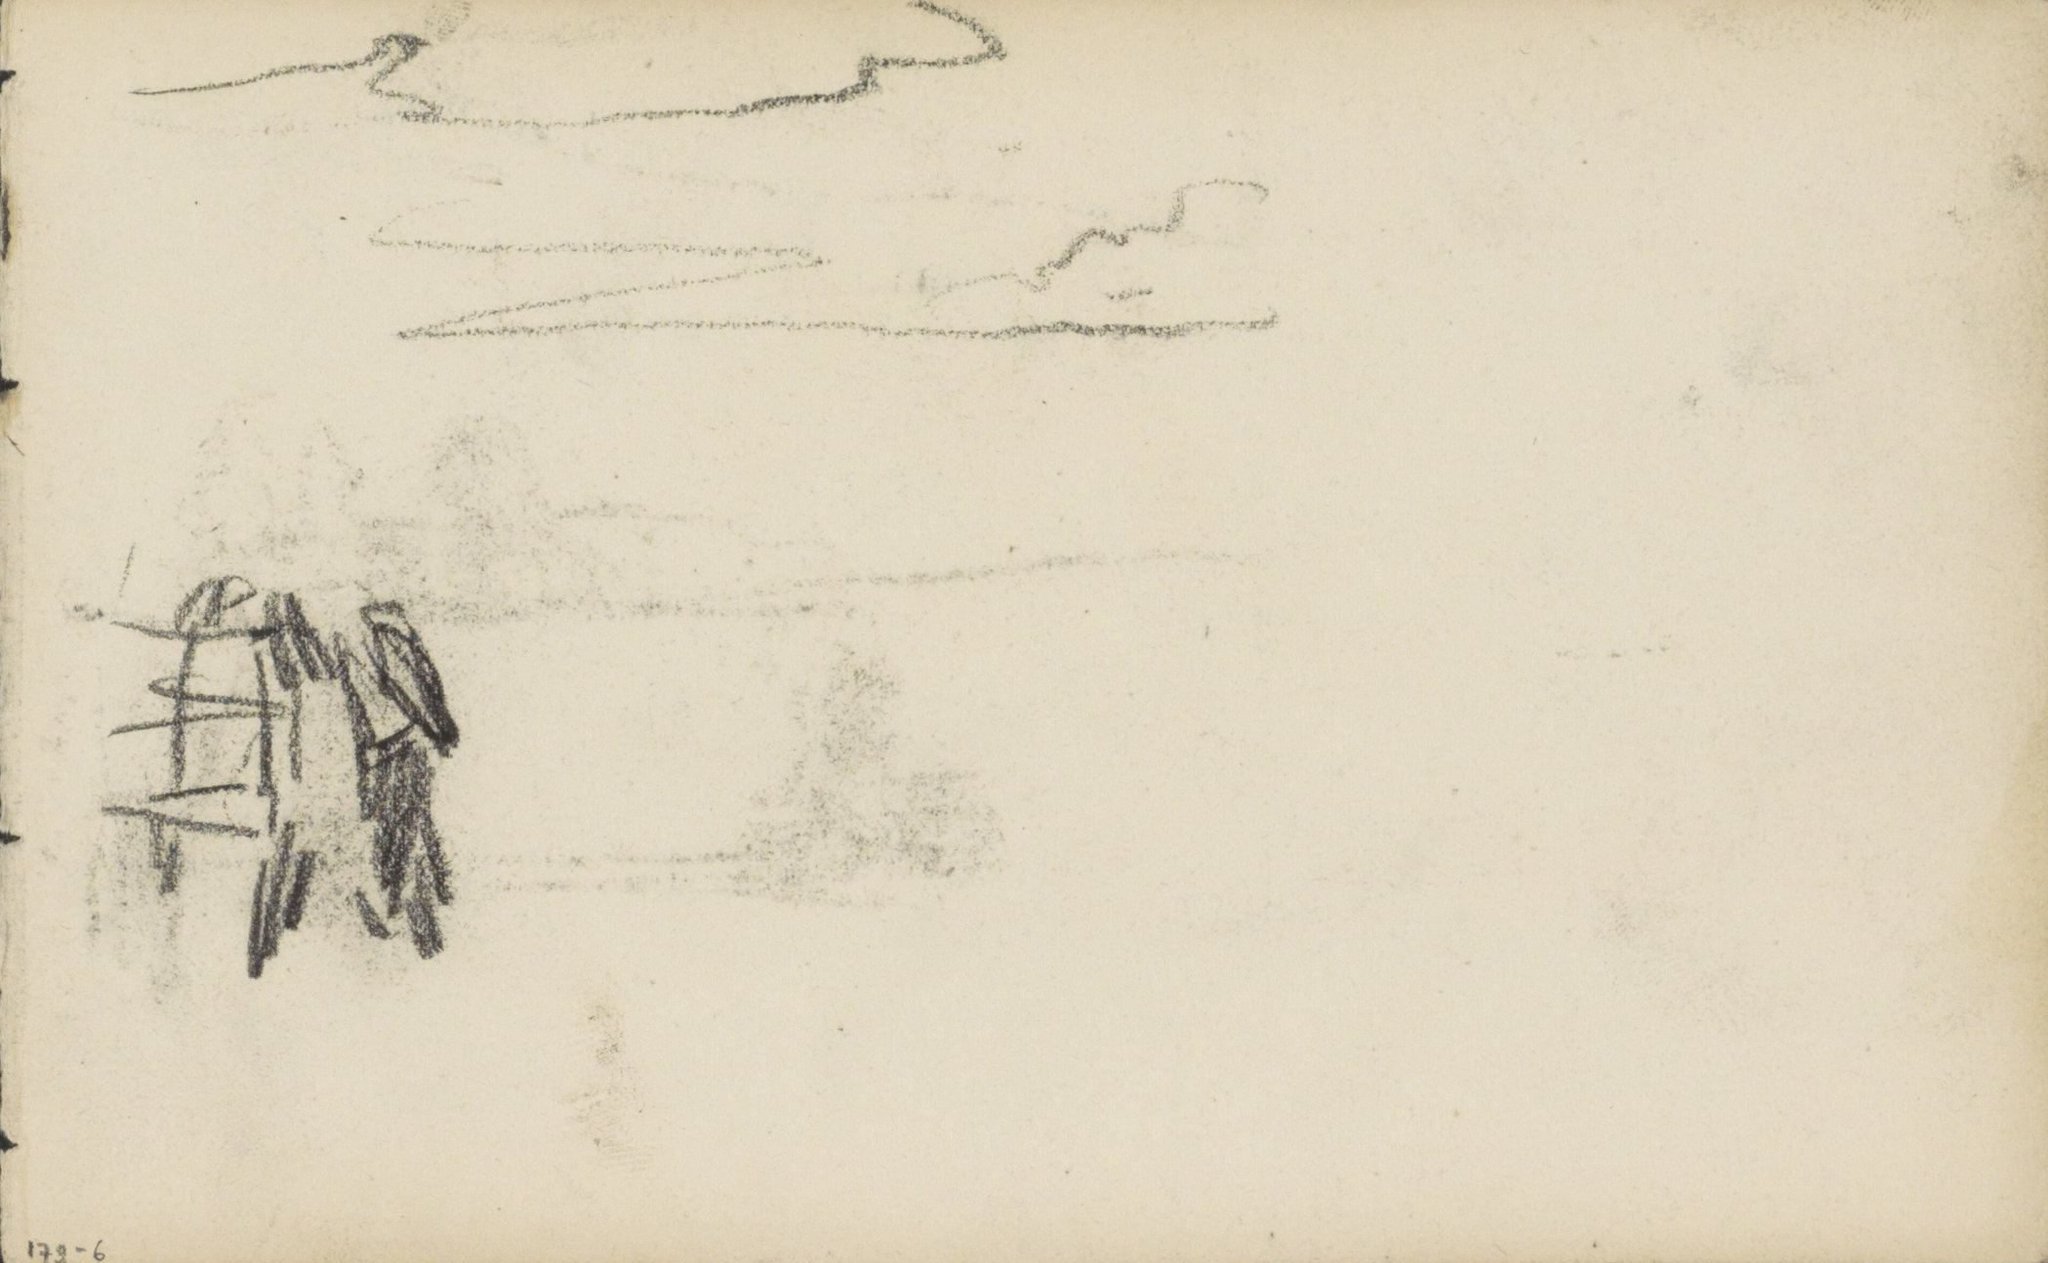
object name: drawing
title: Figuurstudie en een wolkenlucht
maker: george hendrik breitner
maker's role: draughtsman, painter, print maker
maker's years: 1857-1923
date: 1886-1923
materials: chalk, paper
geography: amsterdam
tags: standing figure, clouds